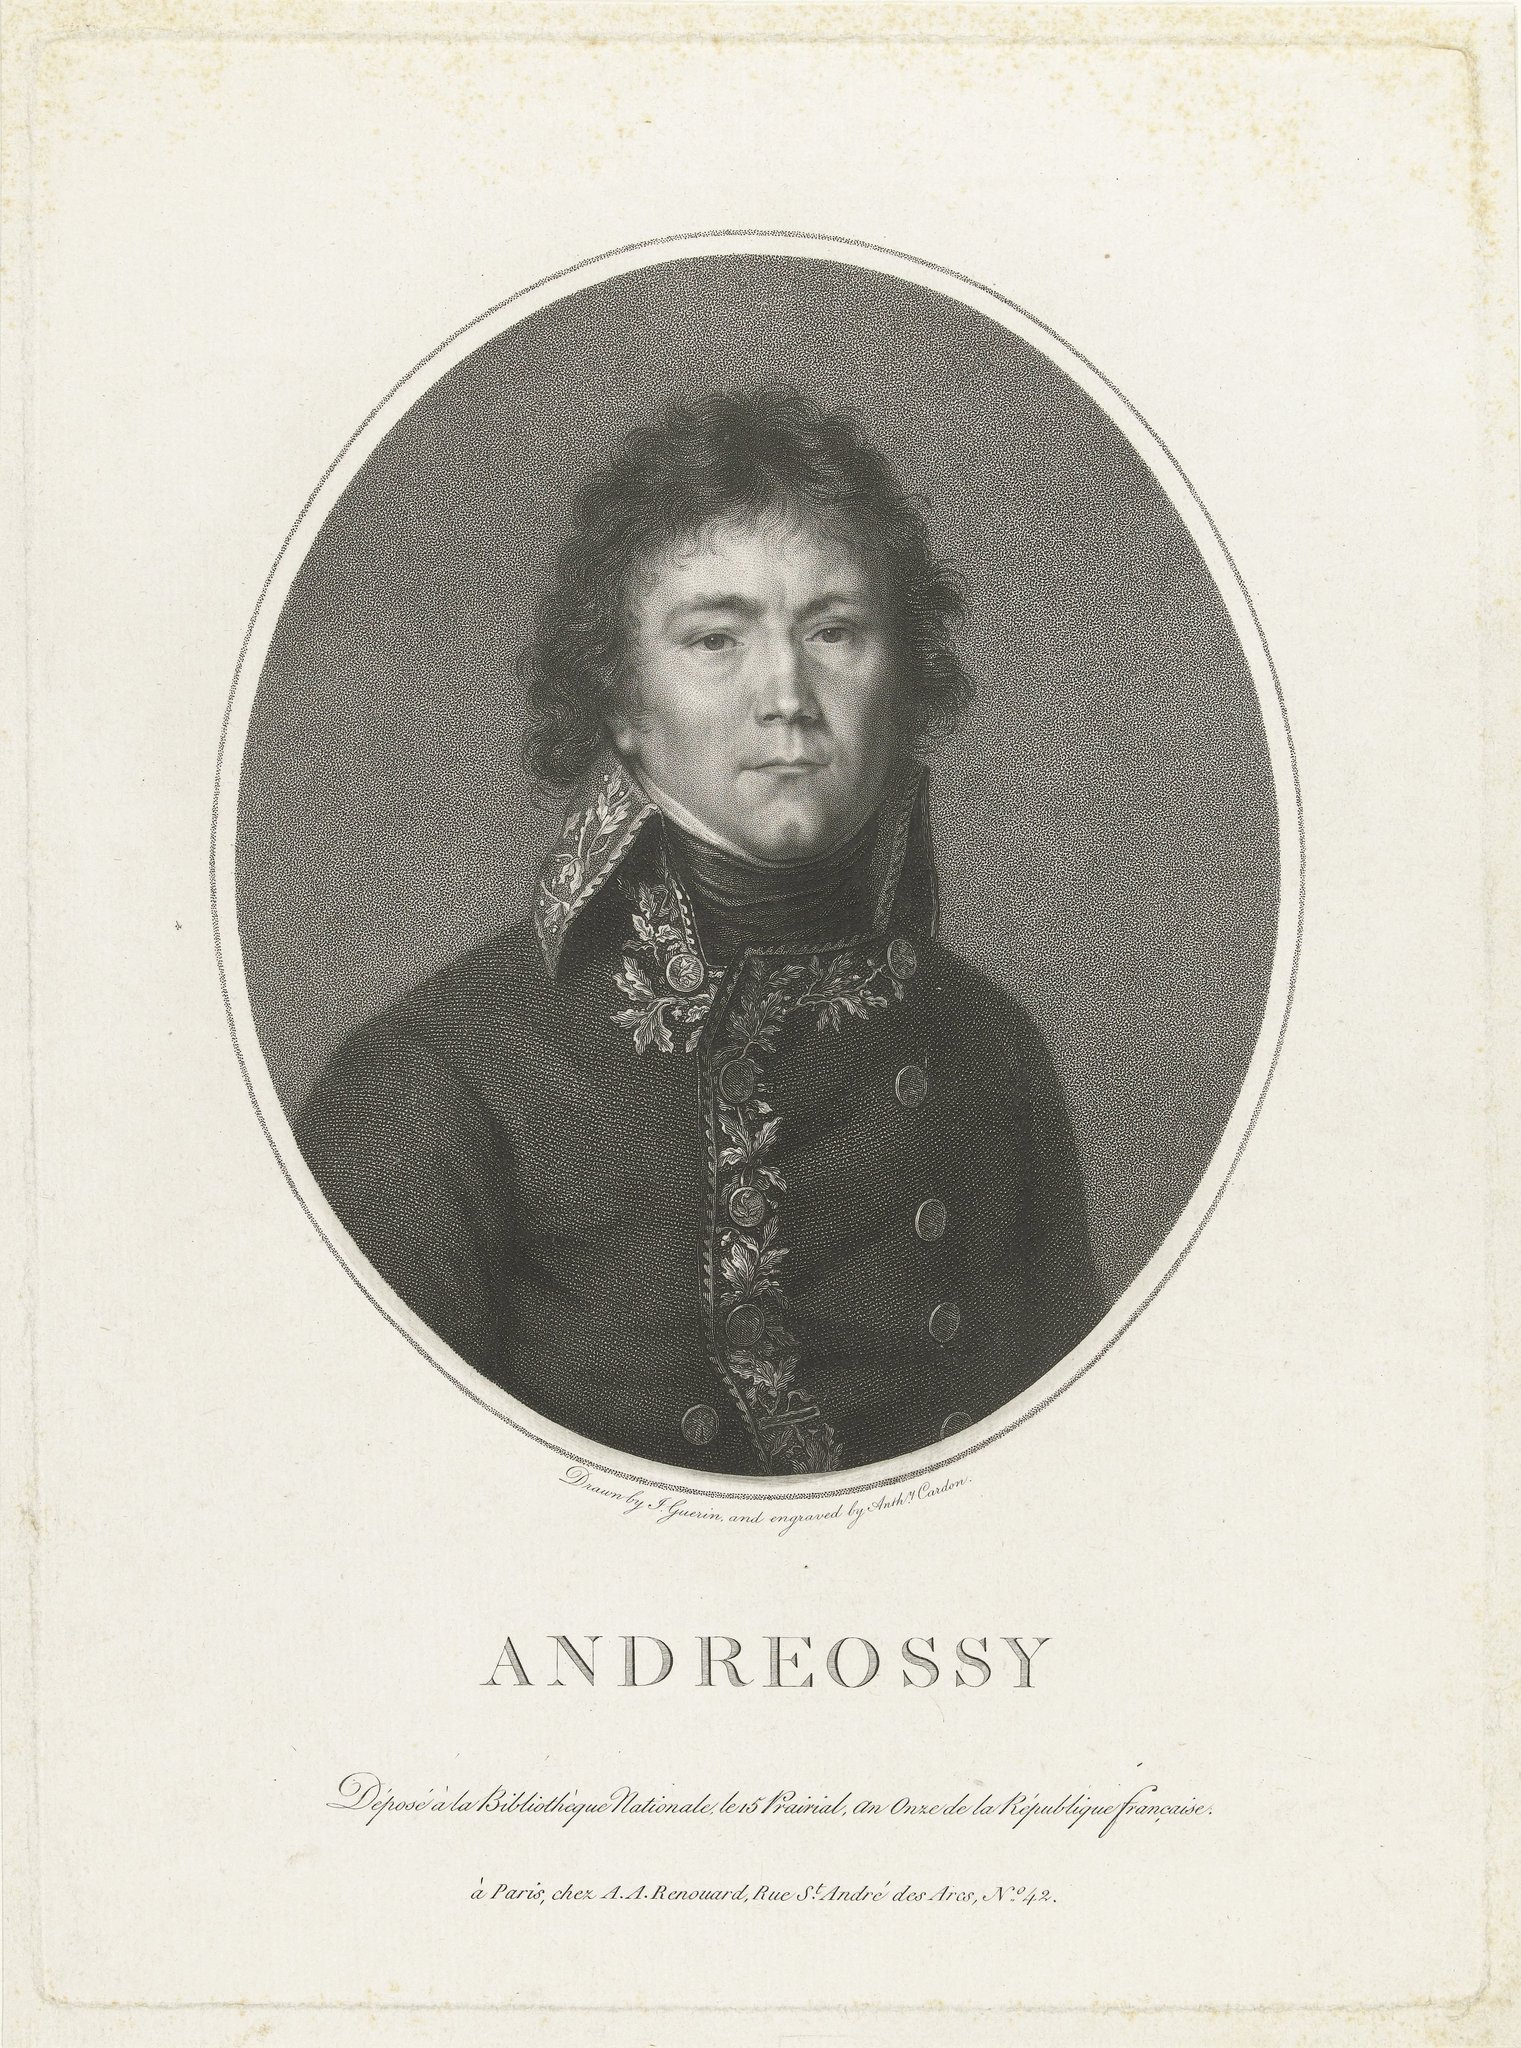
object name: print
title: Portret van generaal Antoine-François Andréossy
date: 1800-1813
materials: paper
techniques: etching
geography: théâtre des folies-marigny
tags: graaf antoine-françois andréossy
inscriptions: collector's mark: Lugt 2228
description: Portret van de Franse generaal Antoine-François Andréossy, in ovaal met uniform. Andréossy was tijdelijk Franse ambassadeur in Engeland.